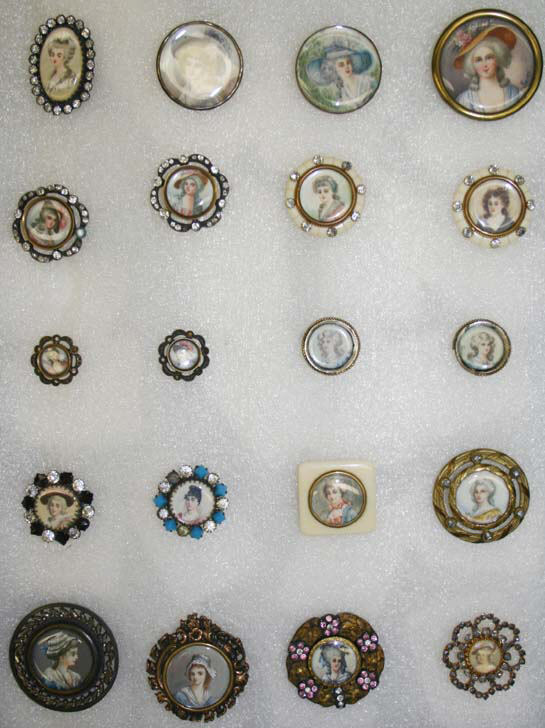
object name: button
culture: french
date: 1850-1880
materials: ivory, metal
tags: portraits,women